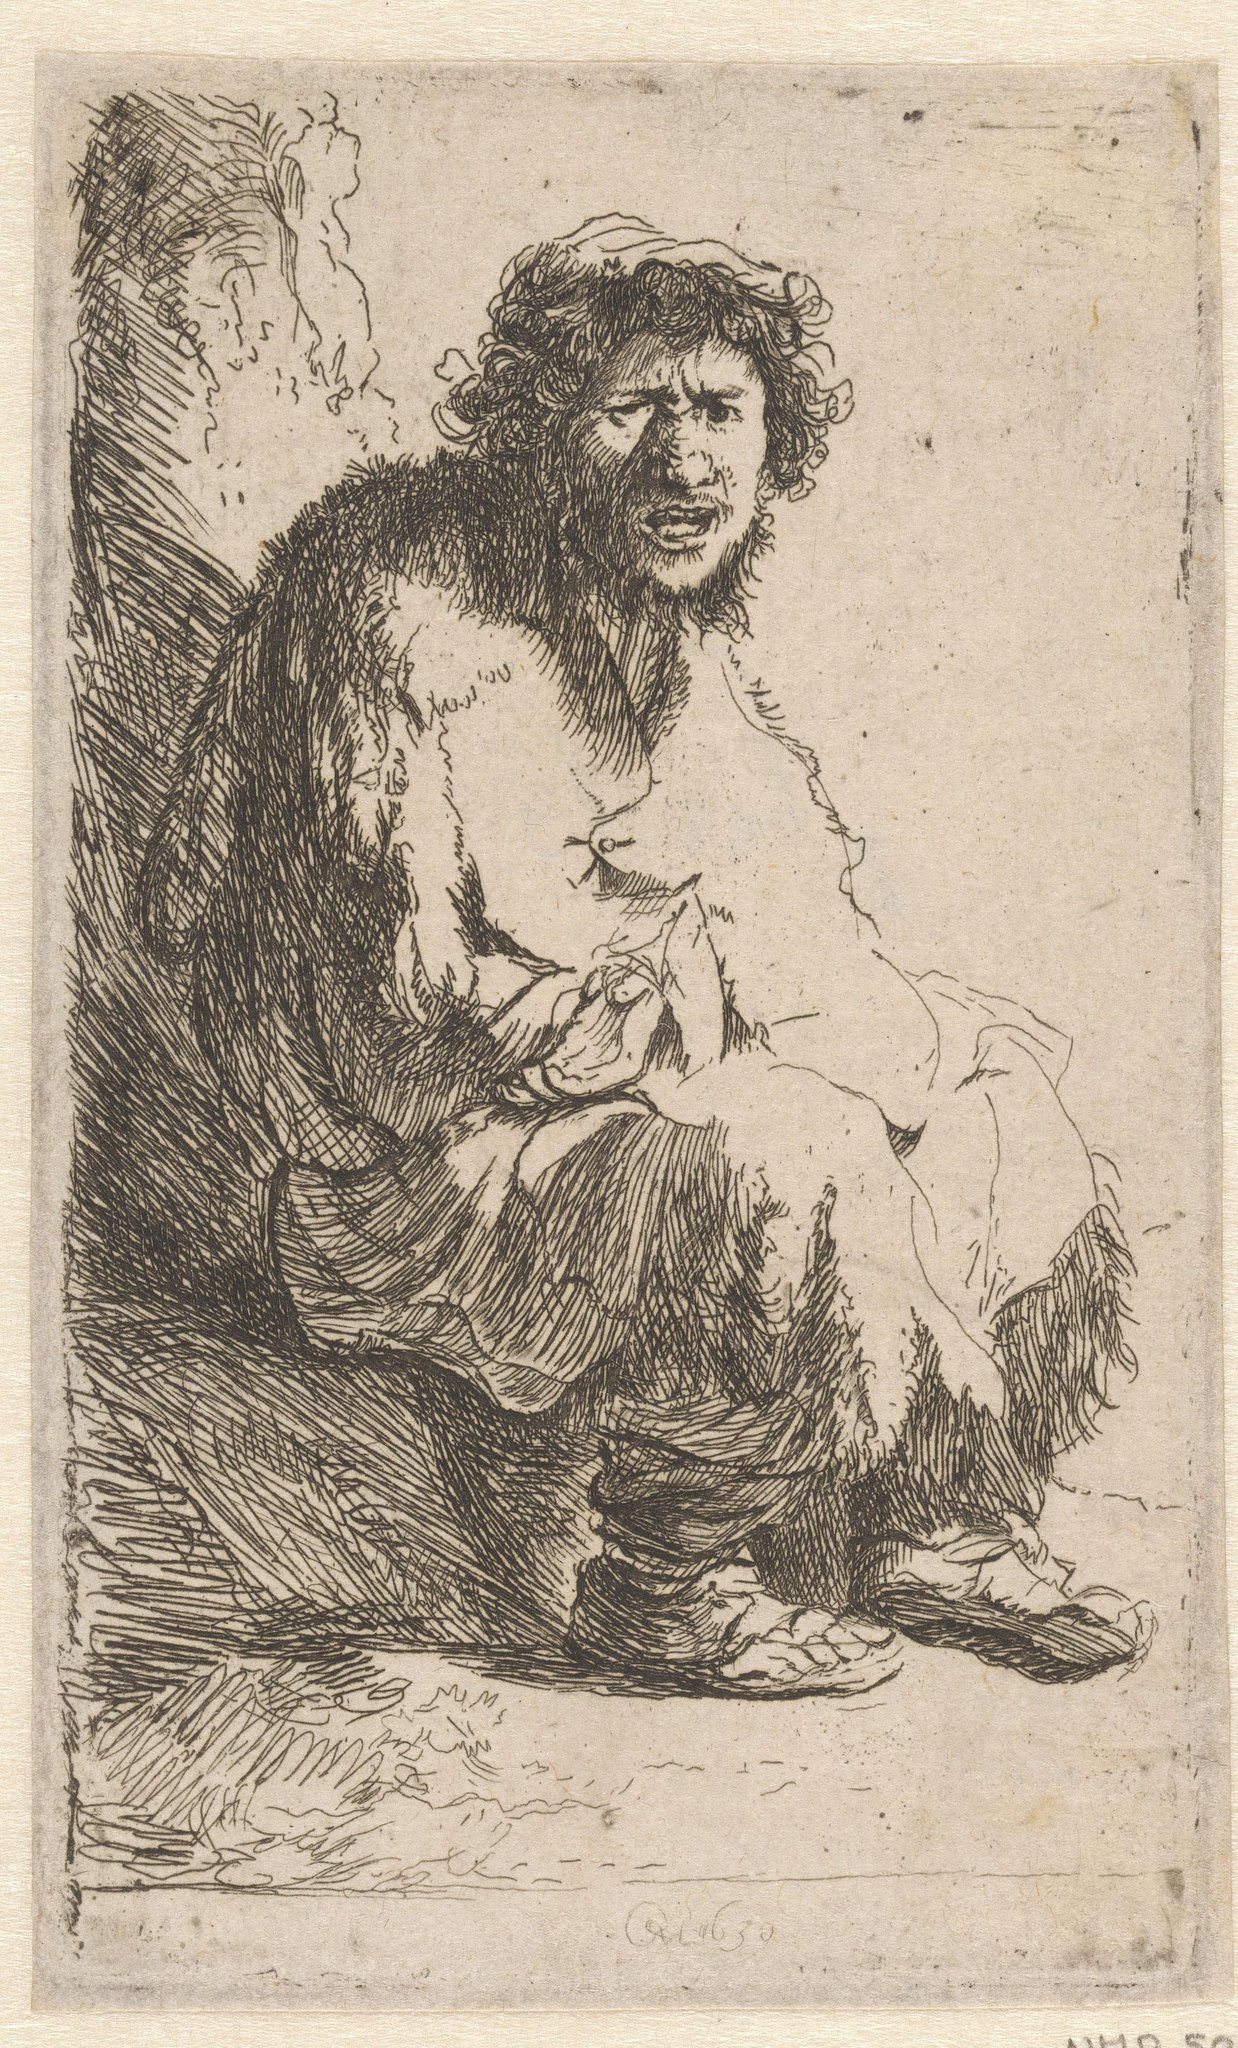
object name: print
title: Beggar seated on a bank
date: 1760-1781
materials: paper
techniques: etching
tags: beggar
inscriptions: collector's mark: Lugt 2760, collector's mark: Lugt 2228